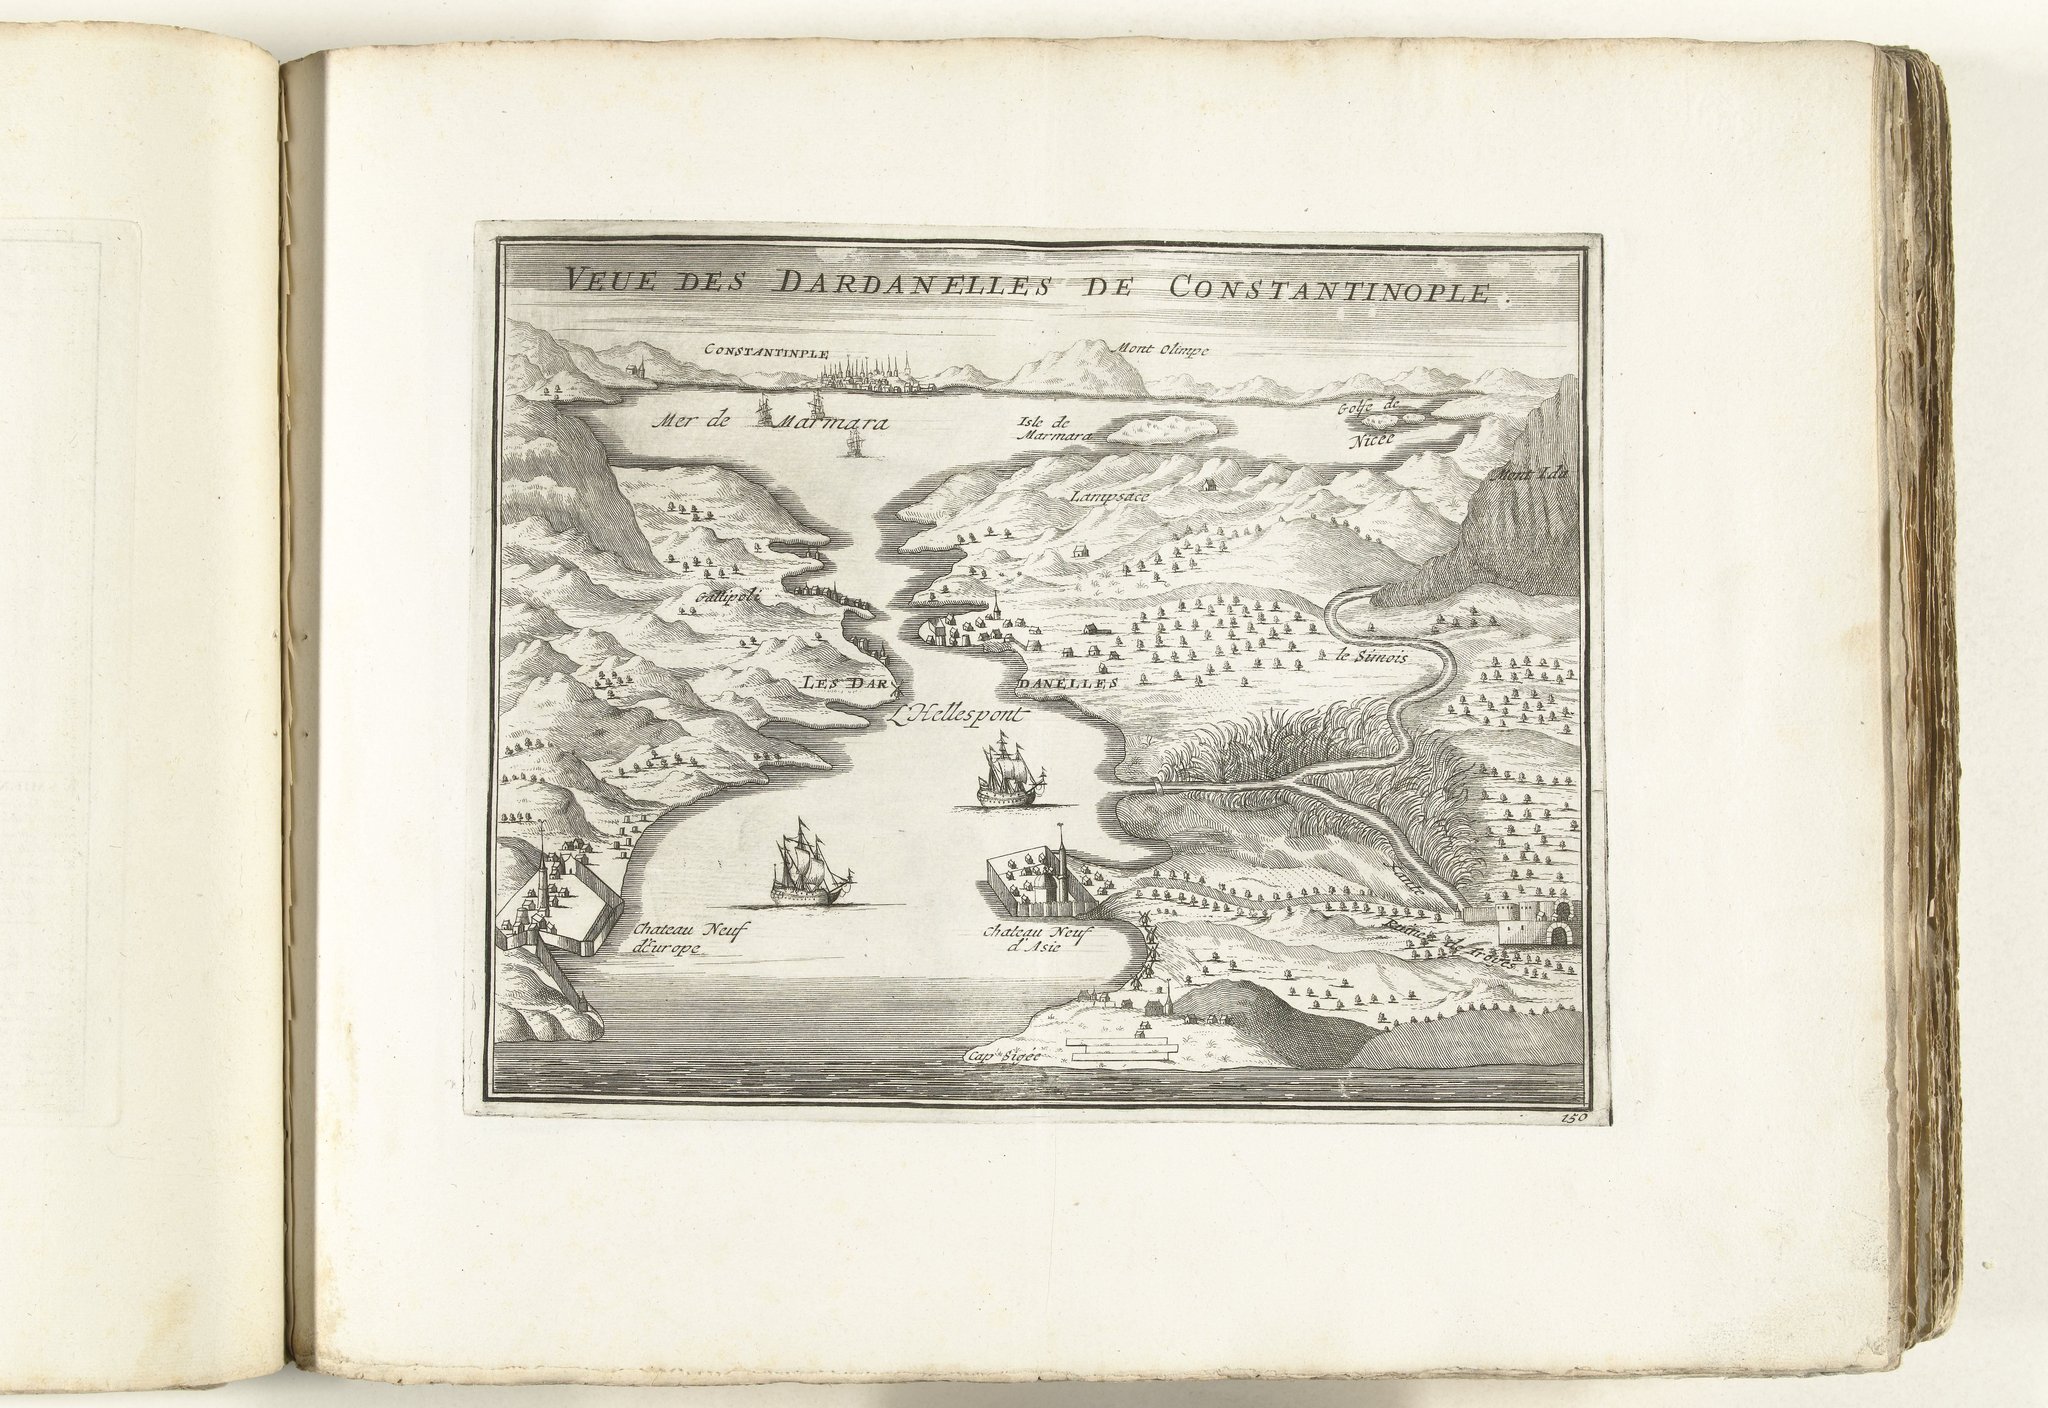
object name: map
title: Gezicht op de Dardanellen, ca. 1702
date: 1702-1703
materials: paper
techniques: etching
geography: amsterdam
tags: maps of separate countries or regions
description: Gezicht op de zeestraat de Dardanellen (Hellespont) met in de verte de Turkse stad Constantinopel. Plaat nr. 150 in het prentwerk bestaande in totaal uit 276 genummerde platen van vermaarde sterke steden en vestingen in het kader van de Spaanse Successieoorlog. Voor het merendeel zijn deze platen gekopieerd naar de anonieme Franse platen: in Les forces de l'Europe en in: Le theatre de la guerre, dans les Pays-Bas, beide oorspronkelijk uitgegeven door Nicolas de Fer te Parijs (1693-1697) in het kader van de Negenjarige Oorlog. Titel en opschriften in de plaat in het Frans.